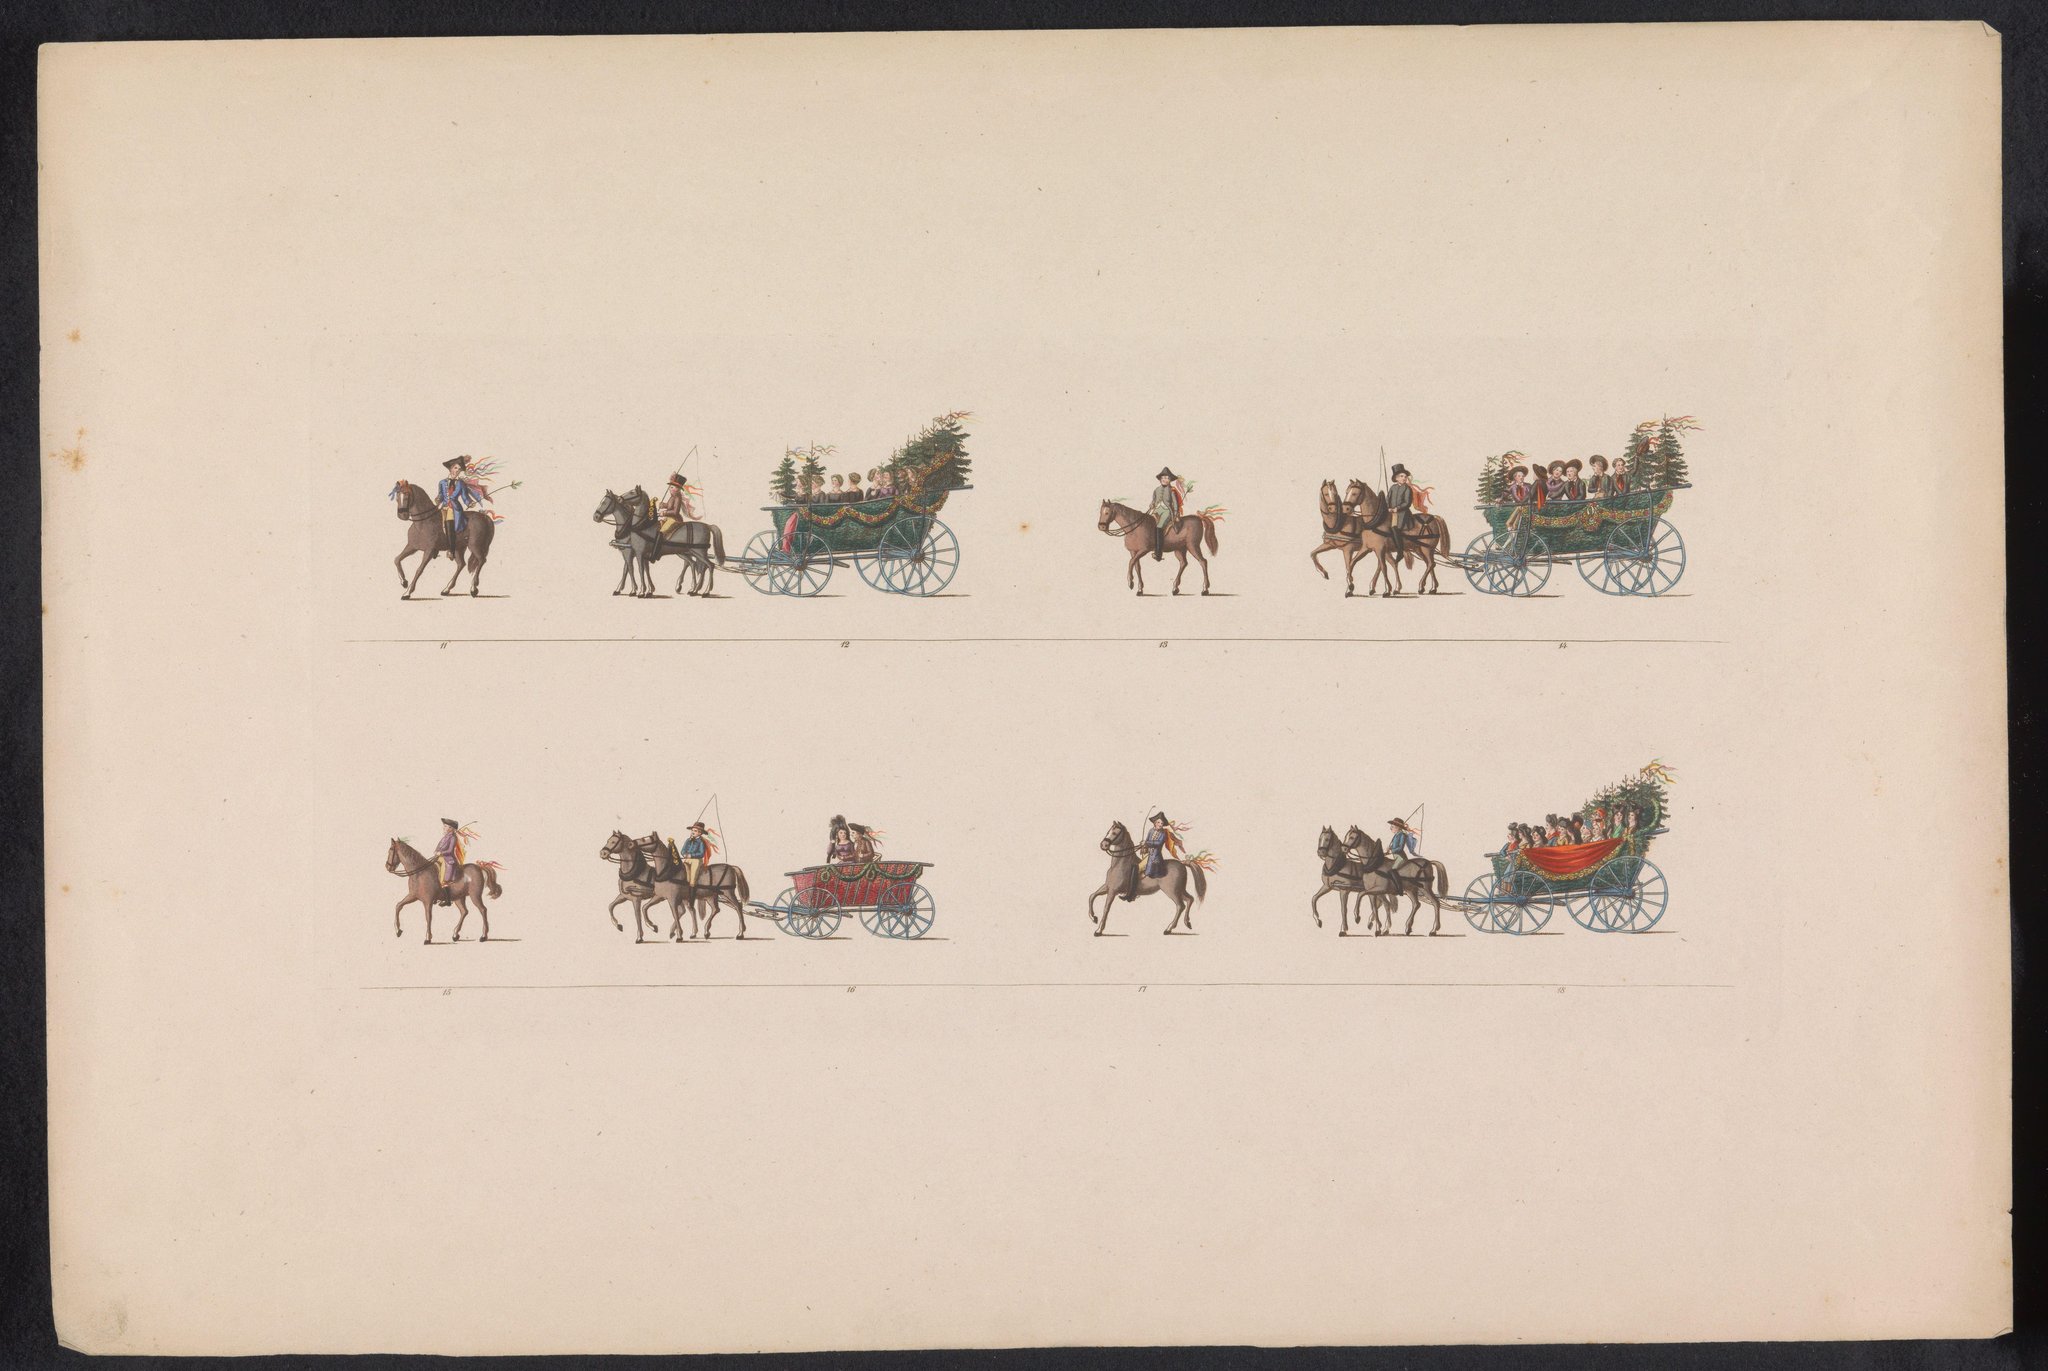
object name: print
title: Optocht bij het huwelijk van Prinses Sophie, 1842 (plaat 2)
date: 1842-1843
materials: paper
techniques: etching, hand coloring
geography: germany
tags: the hague, public festivities at marriage of royal persons (+ parade, pageant, cavalcade ~ festive activities)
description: Optocht ter gelegenheid van het huwelijk van Prinses Sophie met Karel Alexander, groothertog van Saksen-Weimar-Eisenach, gehouden bij de intocht van het paar te Weimar op 27 oktober 1842. Tweede plaat met de groepen genummerd 11-18. Onderdeel van de serie van zes losse platen van de optocht.